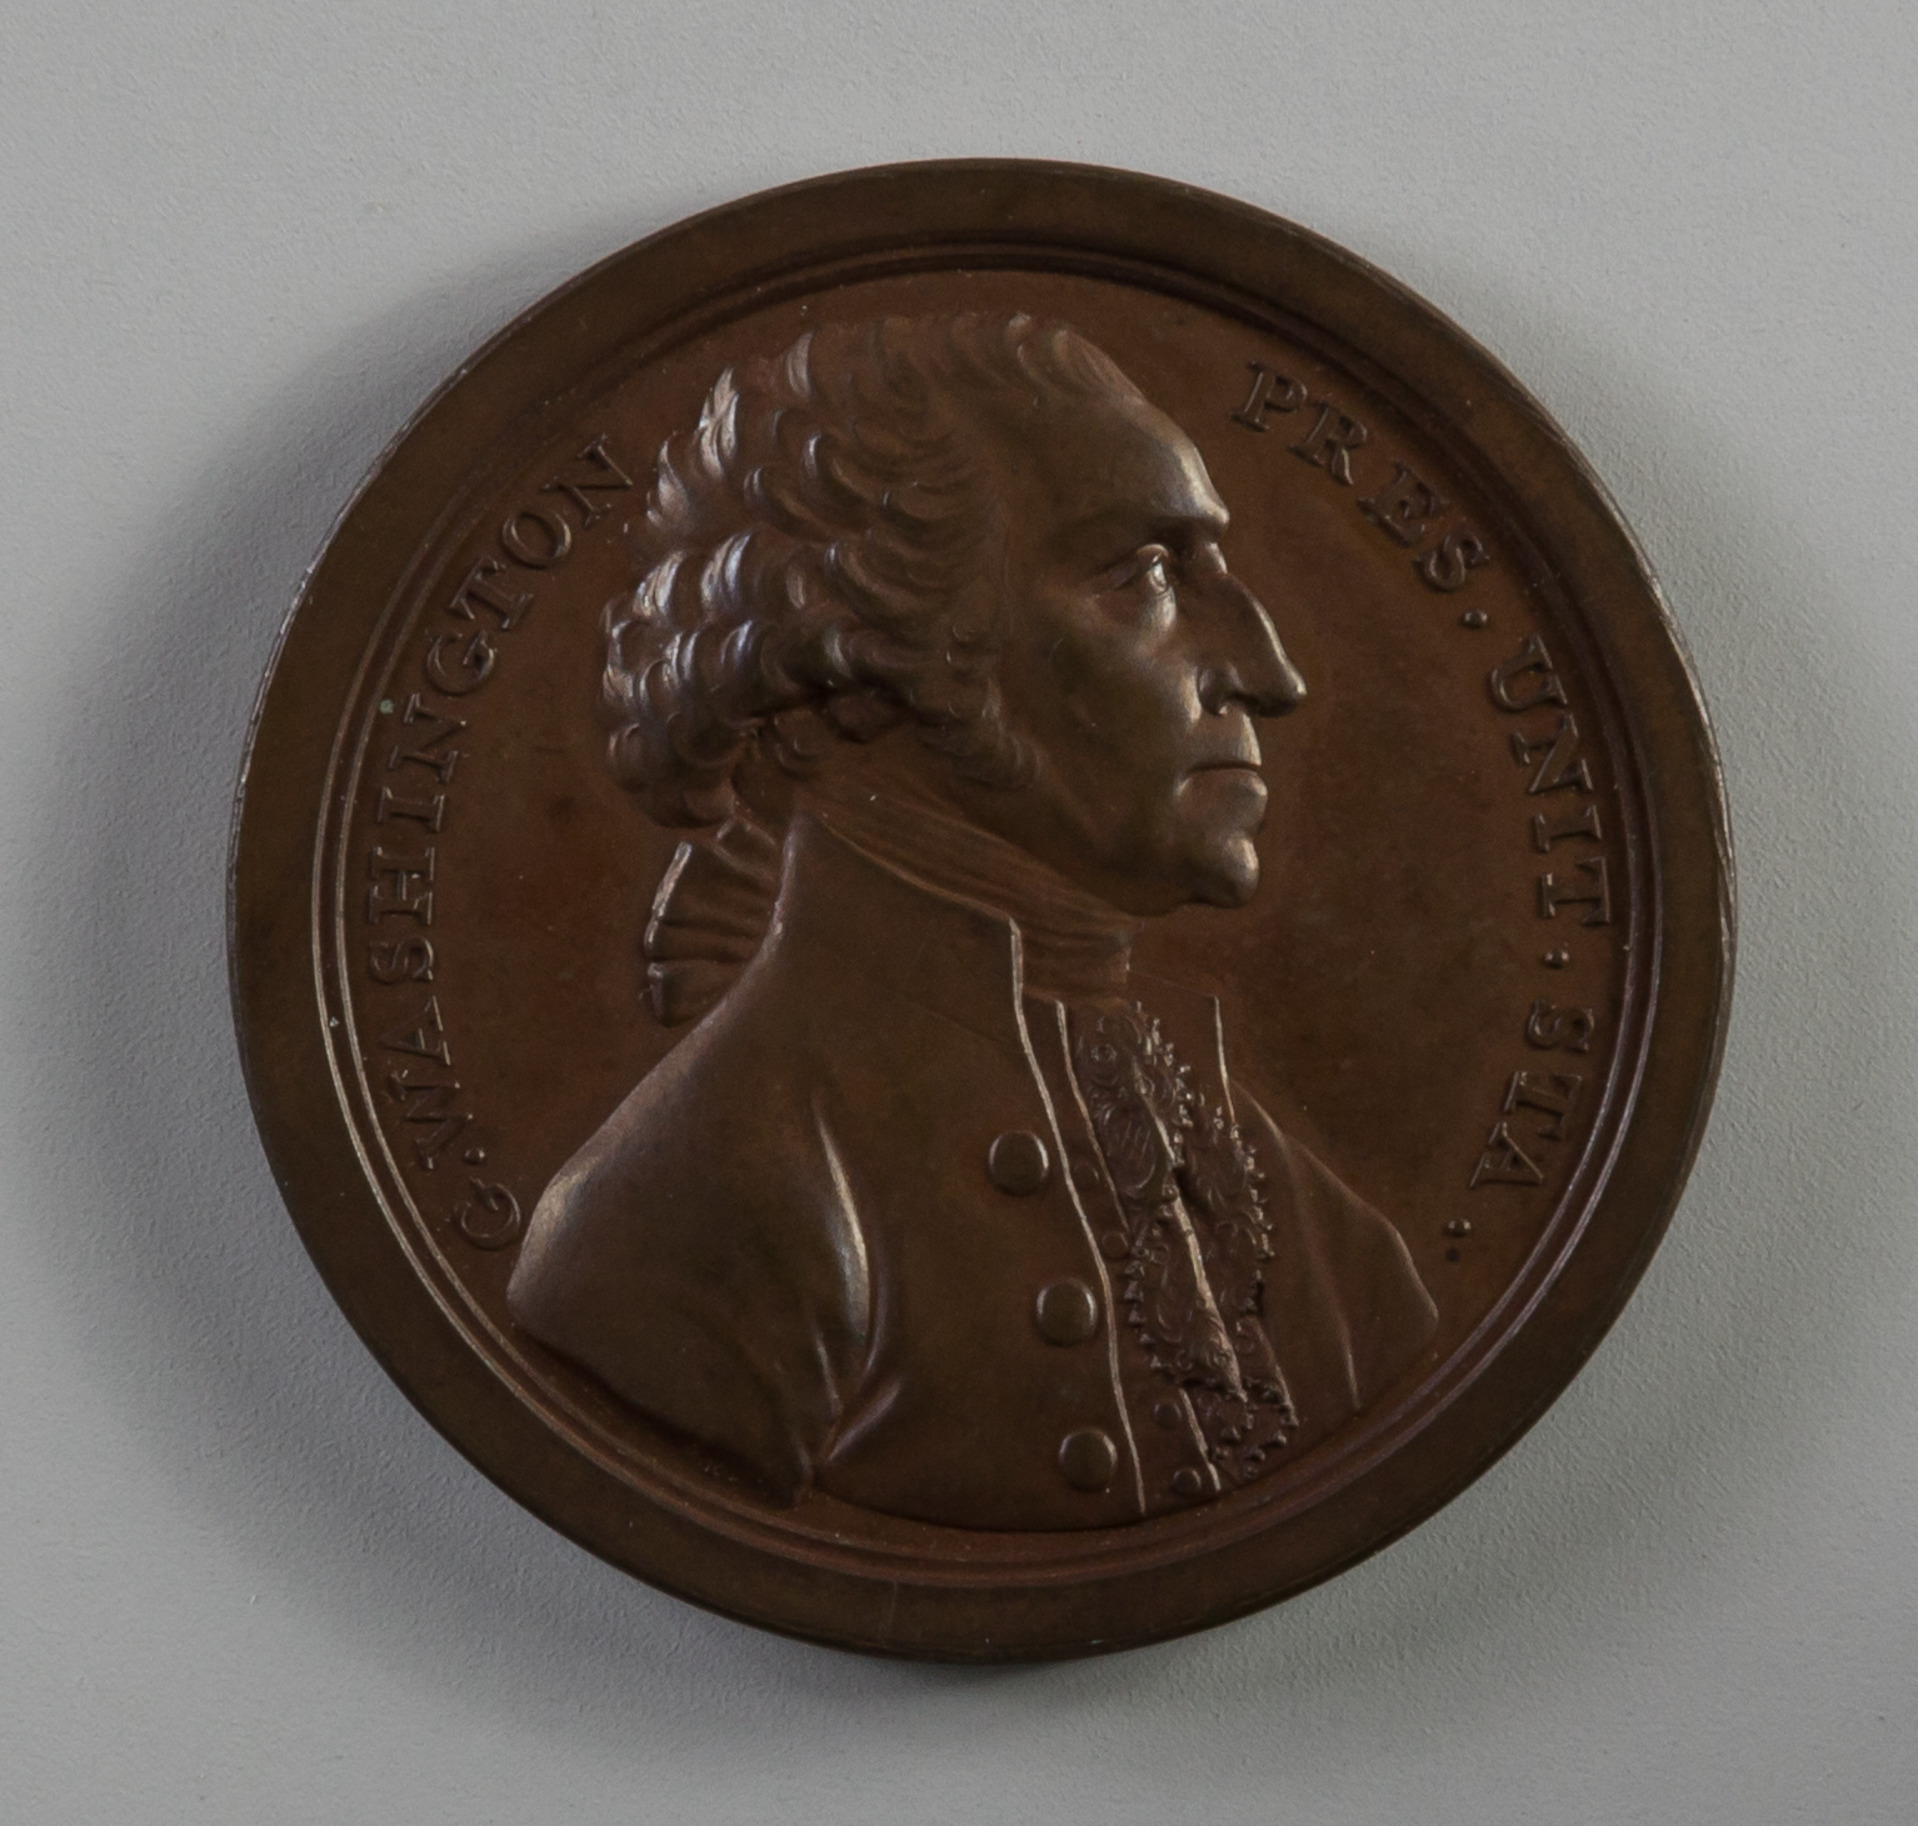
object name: medal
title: Medal Commemorating George Washington's Resignation of the Presidency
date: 1797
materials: bronze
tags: george washington,profiles